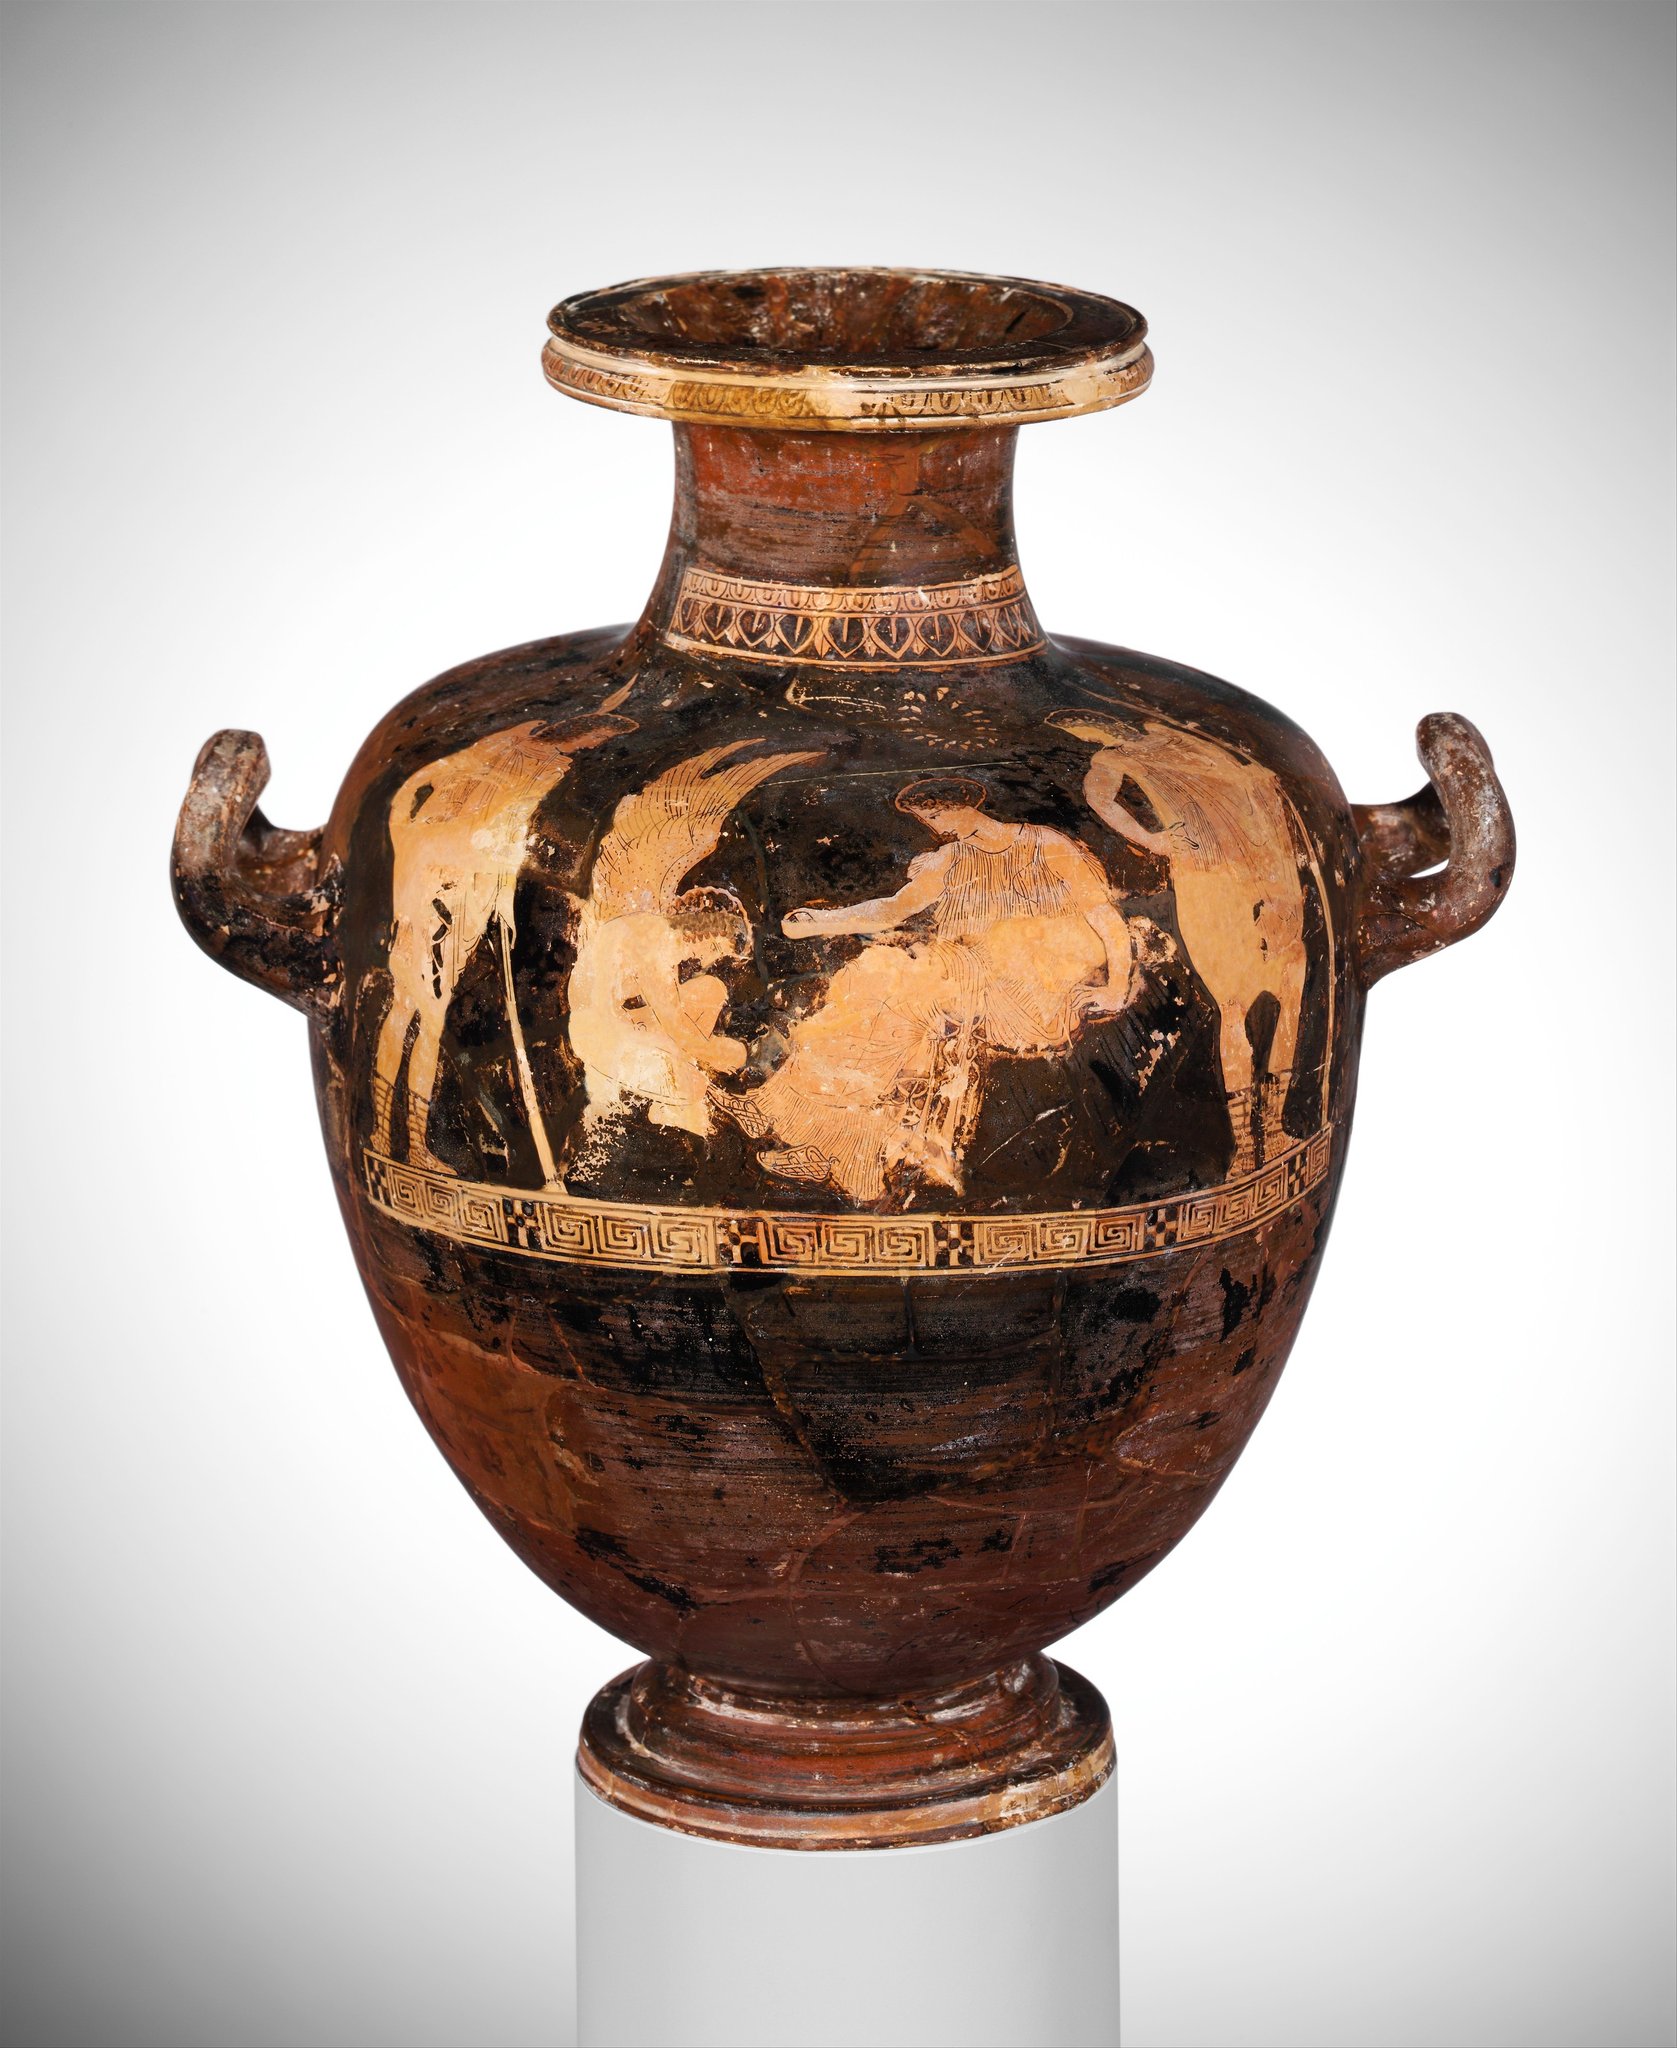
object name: hydria, kalpis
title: Terracotta hydria: kalpis (water jar)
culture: greek, attic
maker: washing painter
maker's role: artist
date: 430-420 BCE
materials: terracotta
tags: men,women,eros